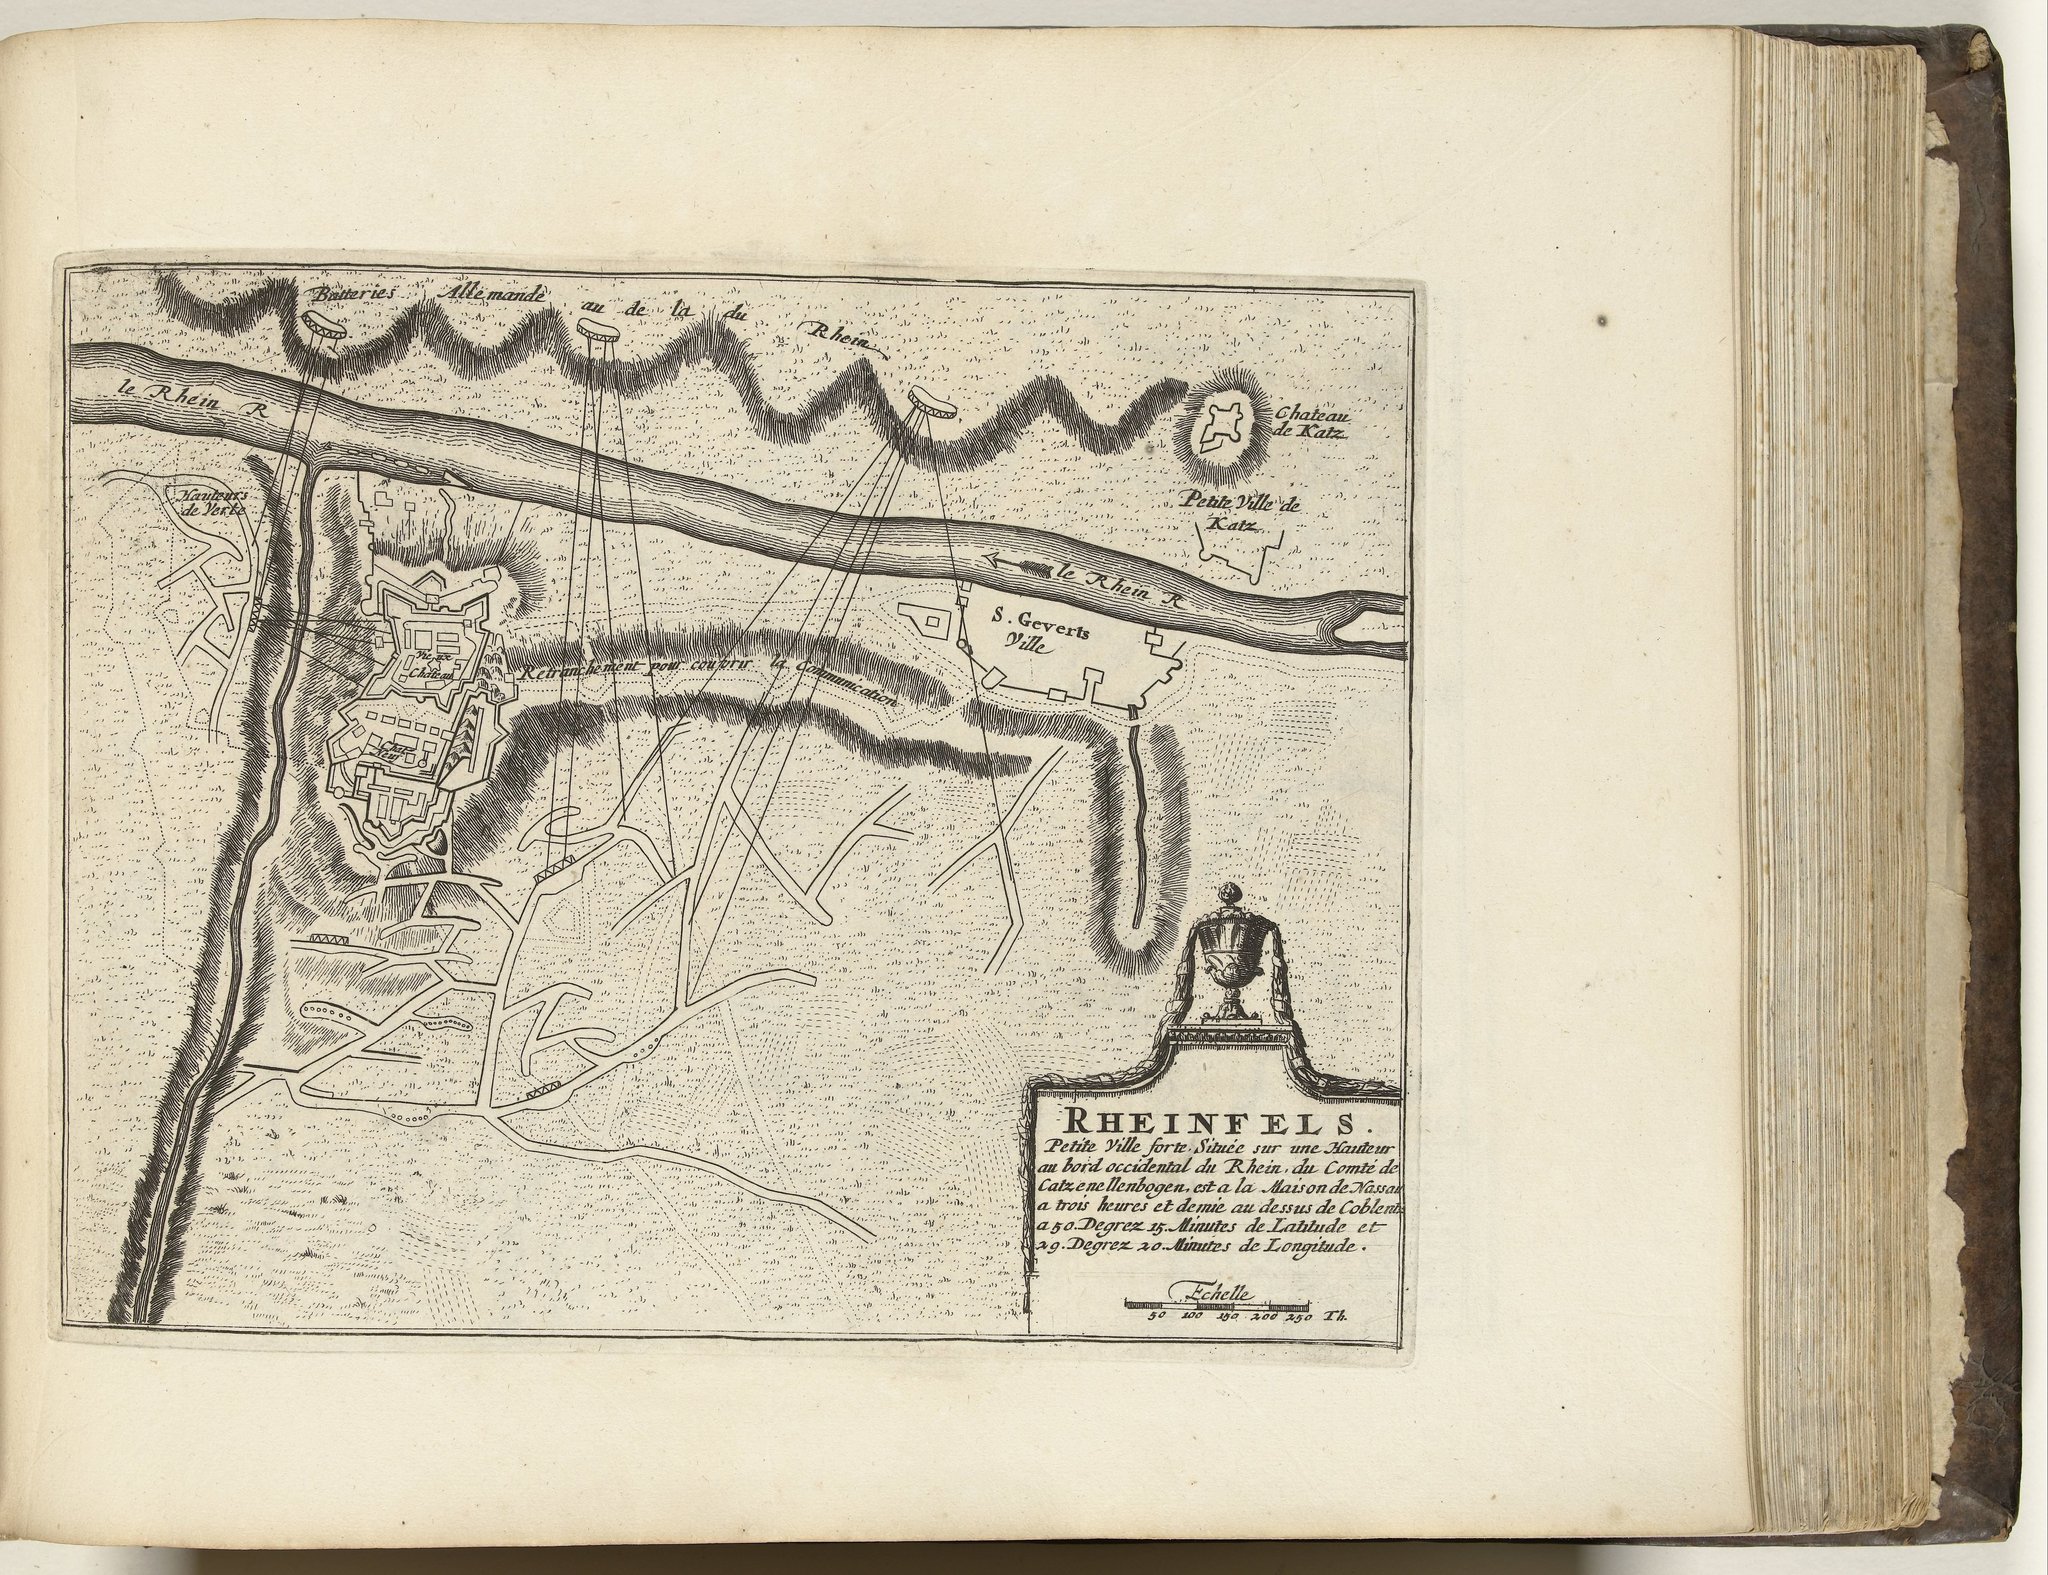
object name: print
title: Plattegrond met het ontzet van Rheinfels, 1693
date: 1693-1696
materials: paper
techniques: etching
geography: france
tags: raising the siege with outside assistance, relief, maps of cities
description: Plattegrond met het ontzet van Rheinfels (dat belegerd werd door de Fransen) door Duitse troepen, januari 1693. Onderdeel van het vijfde deel (1696) van het prentwerk waarin gebundeld zijn de acht delen van Les forces de l'Europe uitgegeven tussen 1693-1697. Het prentwerk bestaat uit 175 platen met plannen (afkomstig van Sébastien Le Prestre, Seigneur de Vauban) van vermaarde sterke steden en vestingen in de Negenjarige Oorlog. Titel en opschriften in het Frans.